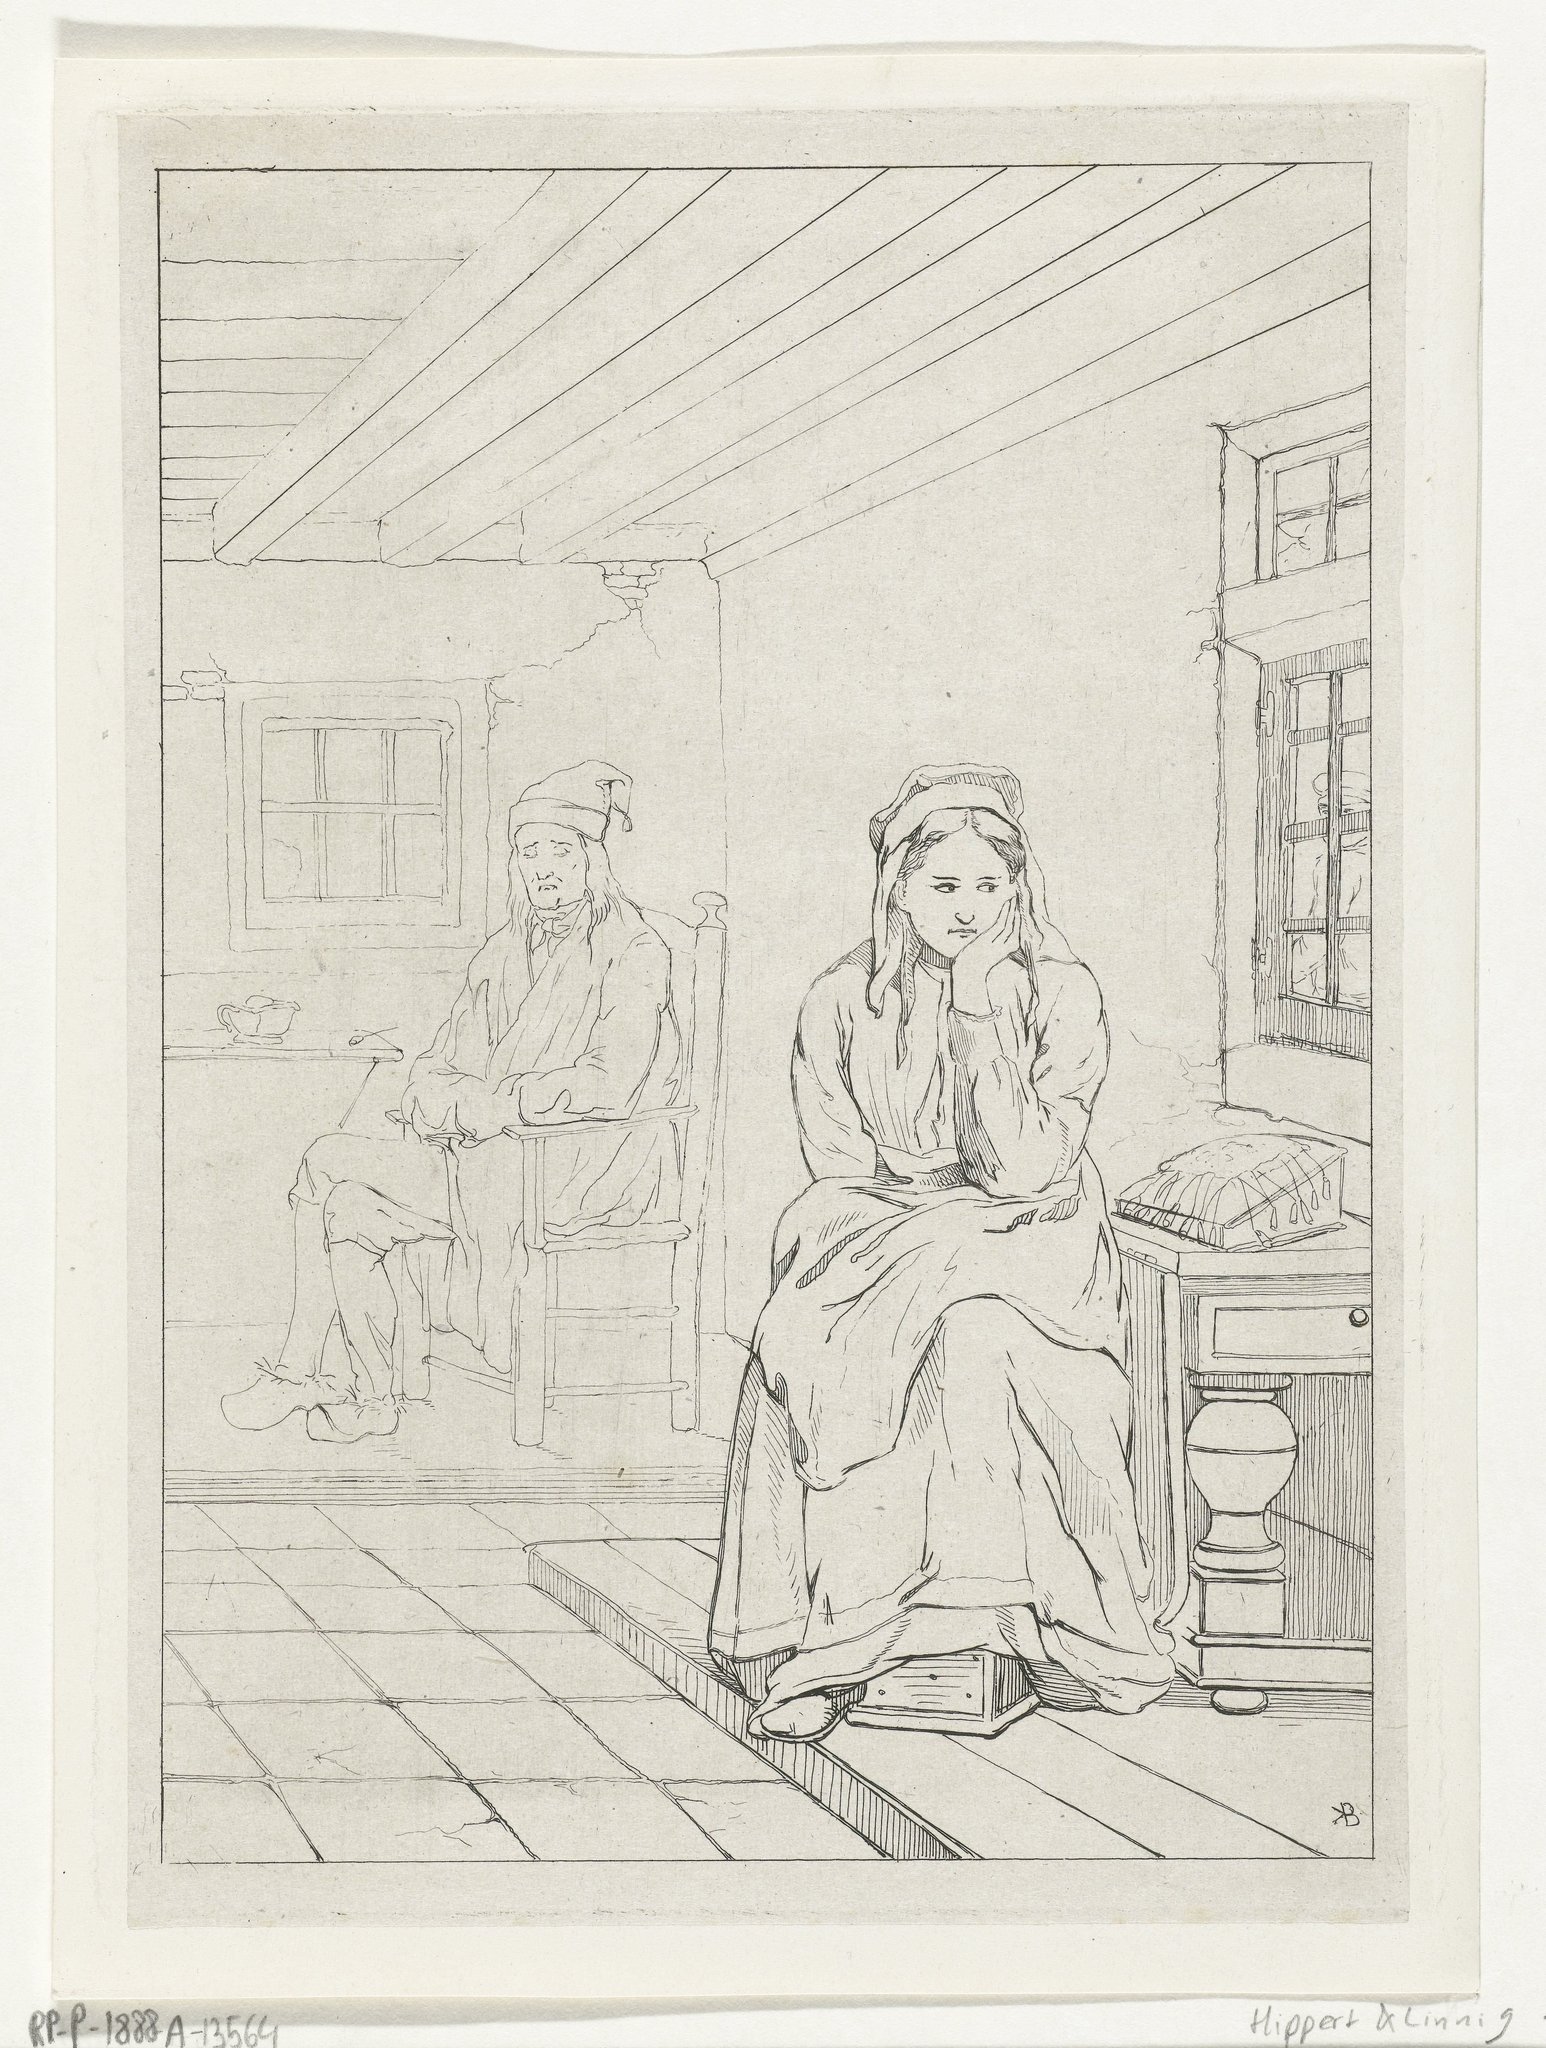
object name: print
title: Verzorgster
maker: karel frederik bombled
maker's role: draughtsman, print maker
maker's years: 1822-1902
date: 1832-1888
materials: paper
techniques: etching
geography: netherlands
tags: sleeping in chair, (other forms of) needlework, e.g.: crocheting, knitting, embroidering, nursing, tending the sick, lover (woman) alone (e.g. longing for the beloved), the (nude) human figure; 'corpo humano' (ripa) (+ old male (human being))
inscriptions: collector's mark: Lugt 2228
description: Achterin de kamer zit een oude man in een stoel te slapen. Rechts op de voorgrond zit zijn verzorgster verveeld (verliefd?)uit het raam te kijken. Haar borduurwerk ligt onberoerd naast haar op tafel. Door het raam kan men de contouren van een jongeling herkennen.